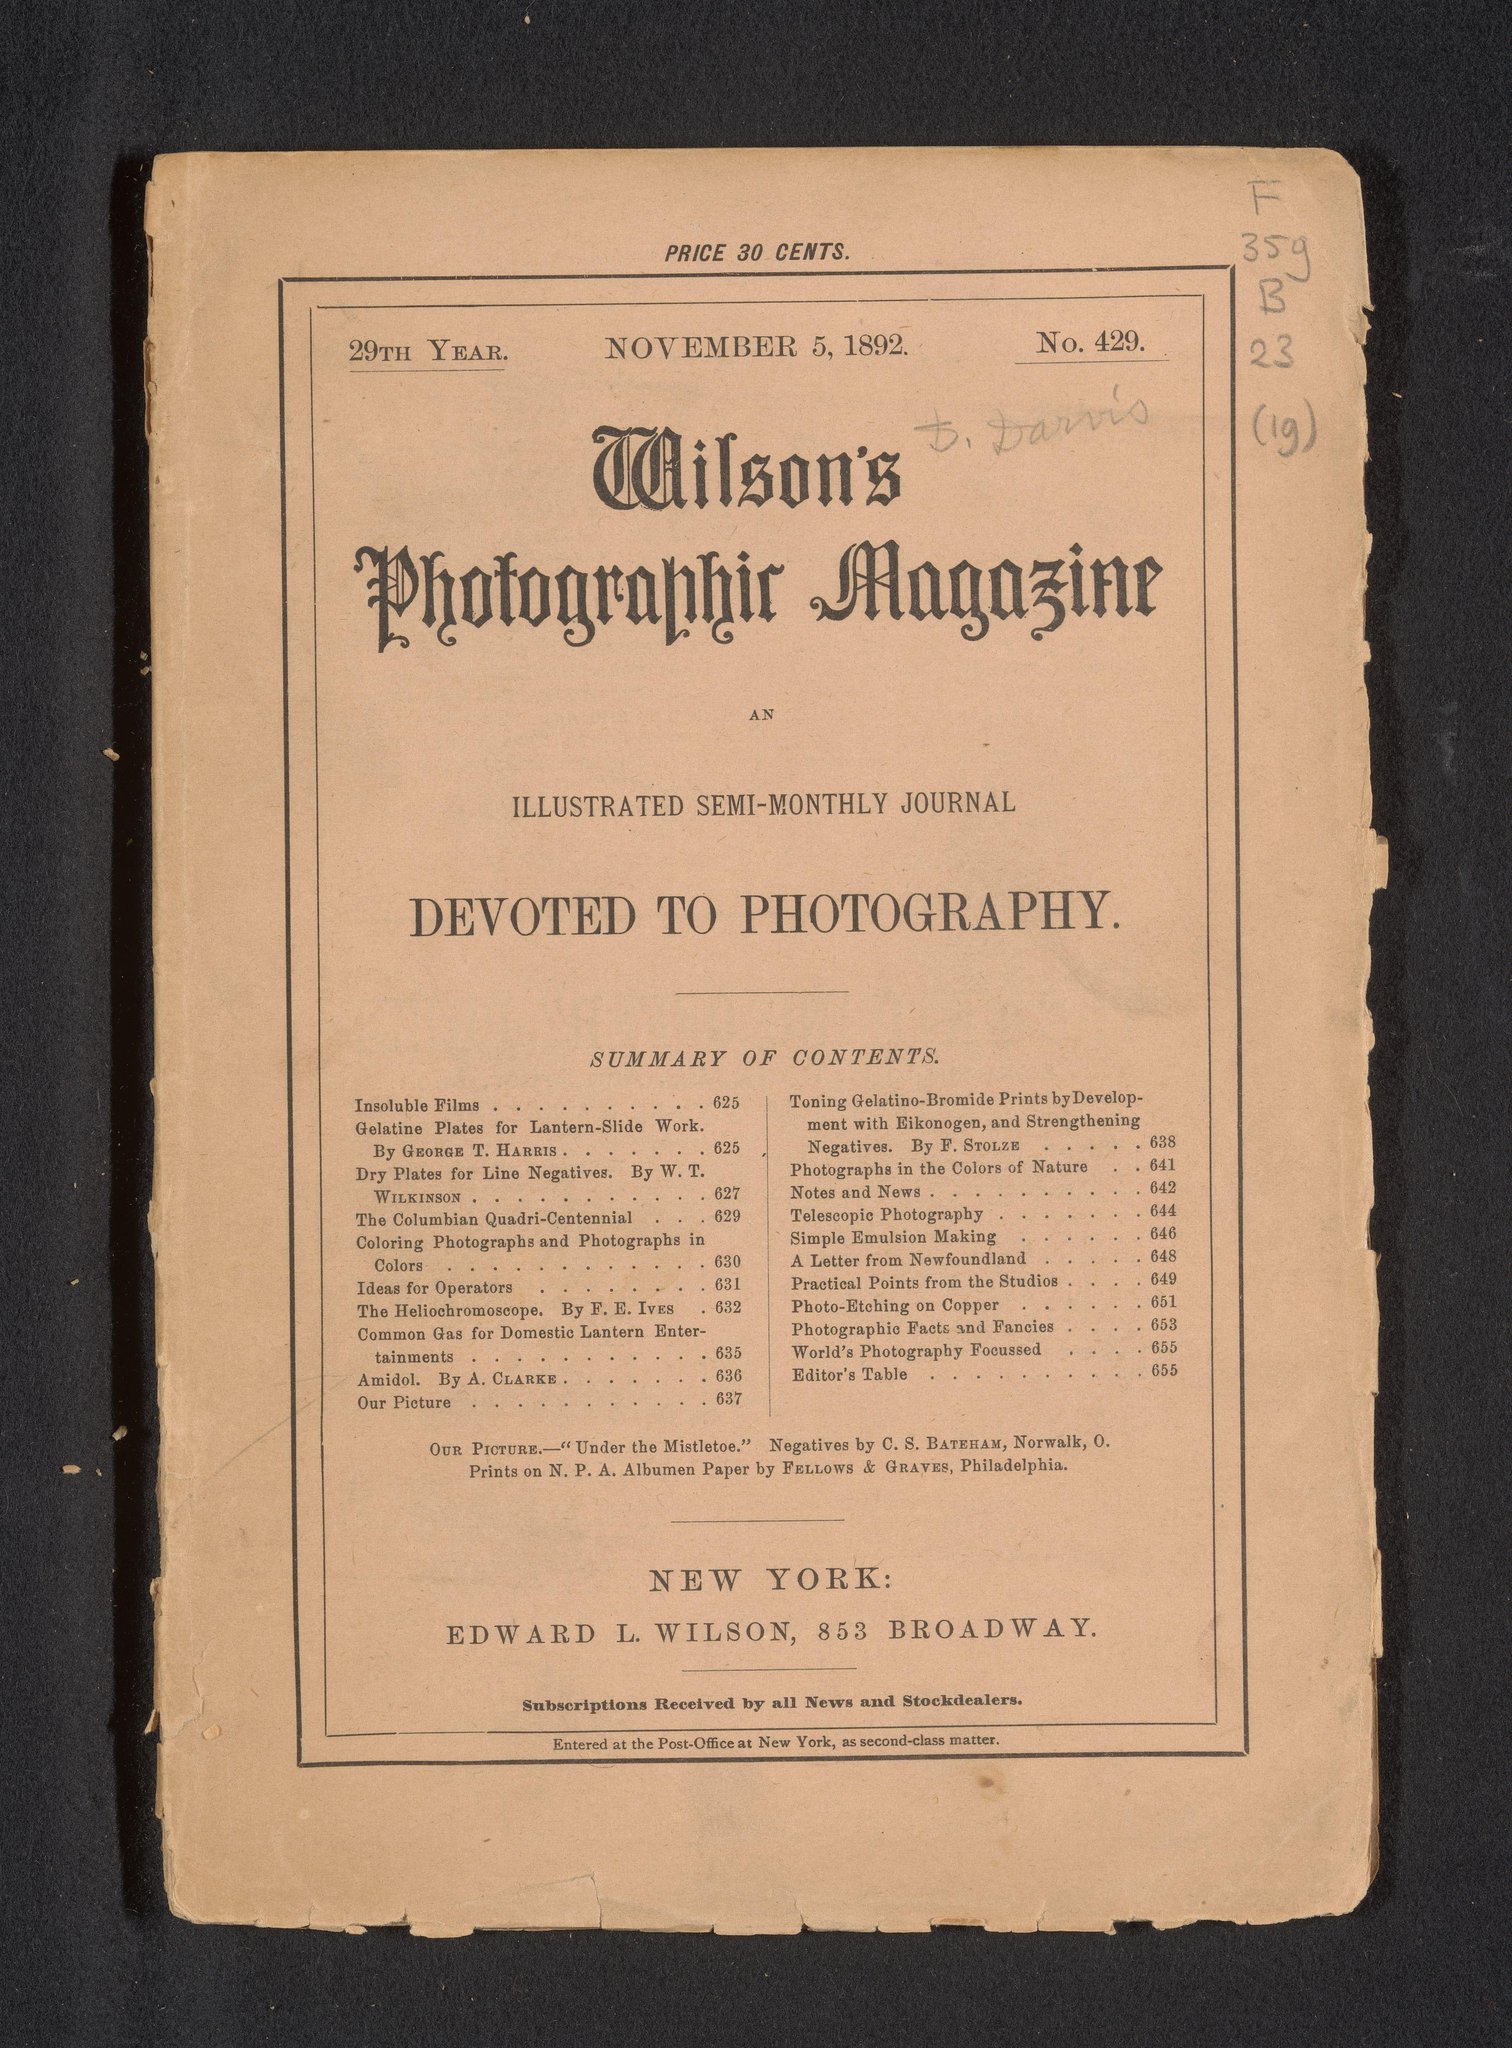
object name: magazine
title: Wilson's photographic magazine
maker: edward livingston wilson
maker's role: publisher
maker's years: 1838-1903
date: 1892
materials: paper, photographic support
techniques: albumen print, printing, engraving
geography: new york city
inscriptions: name: ‘D. Davis’